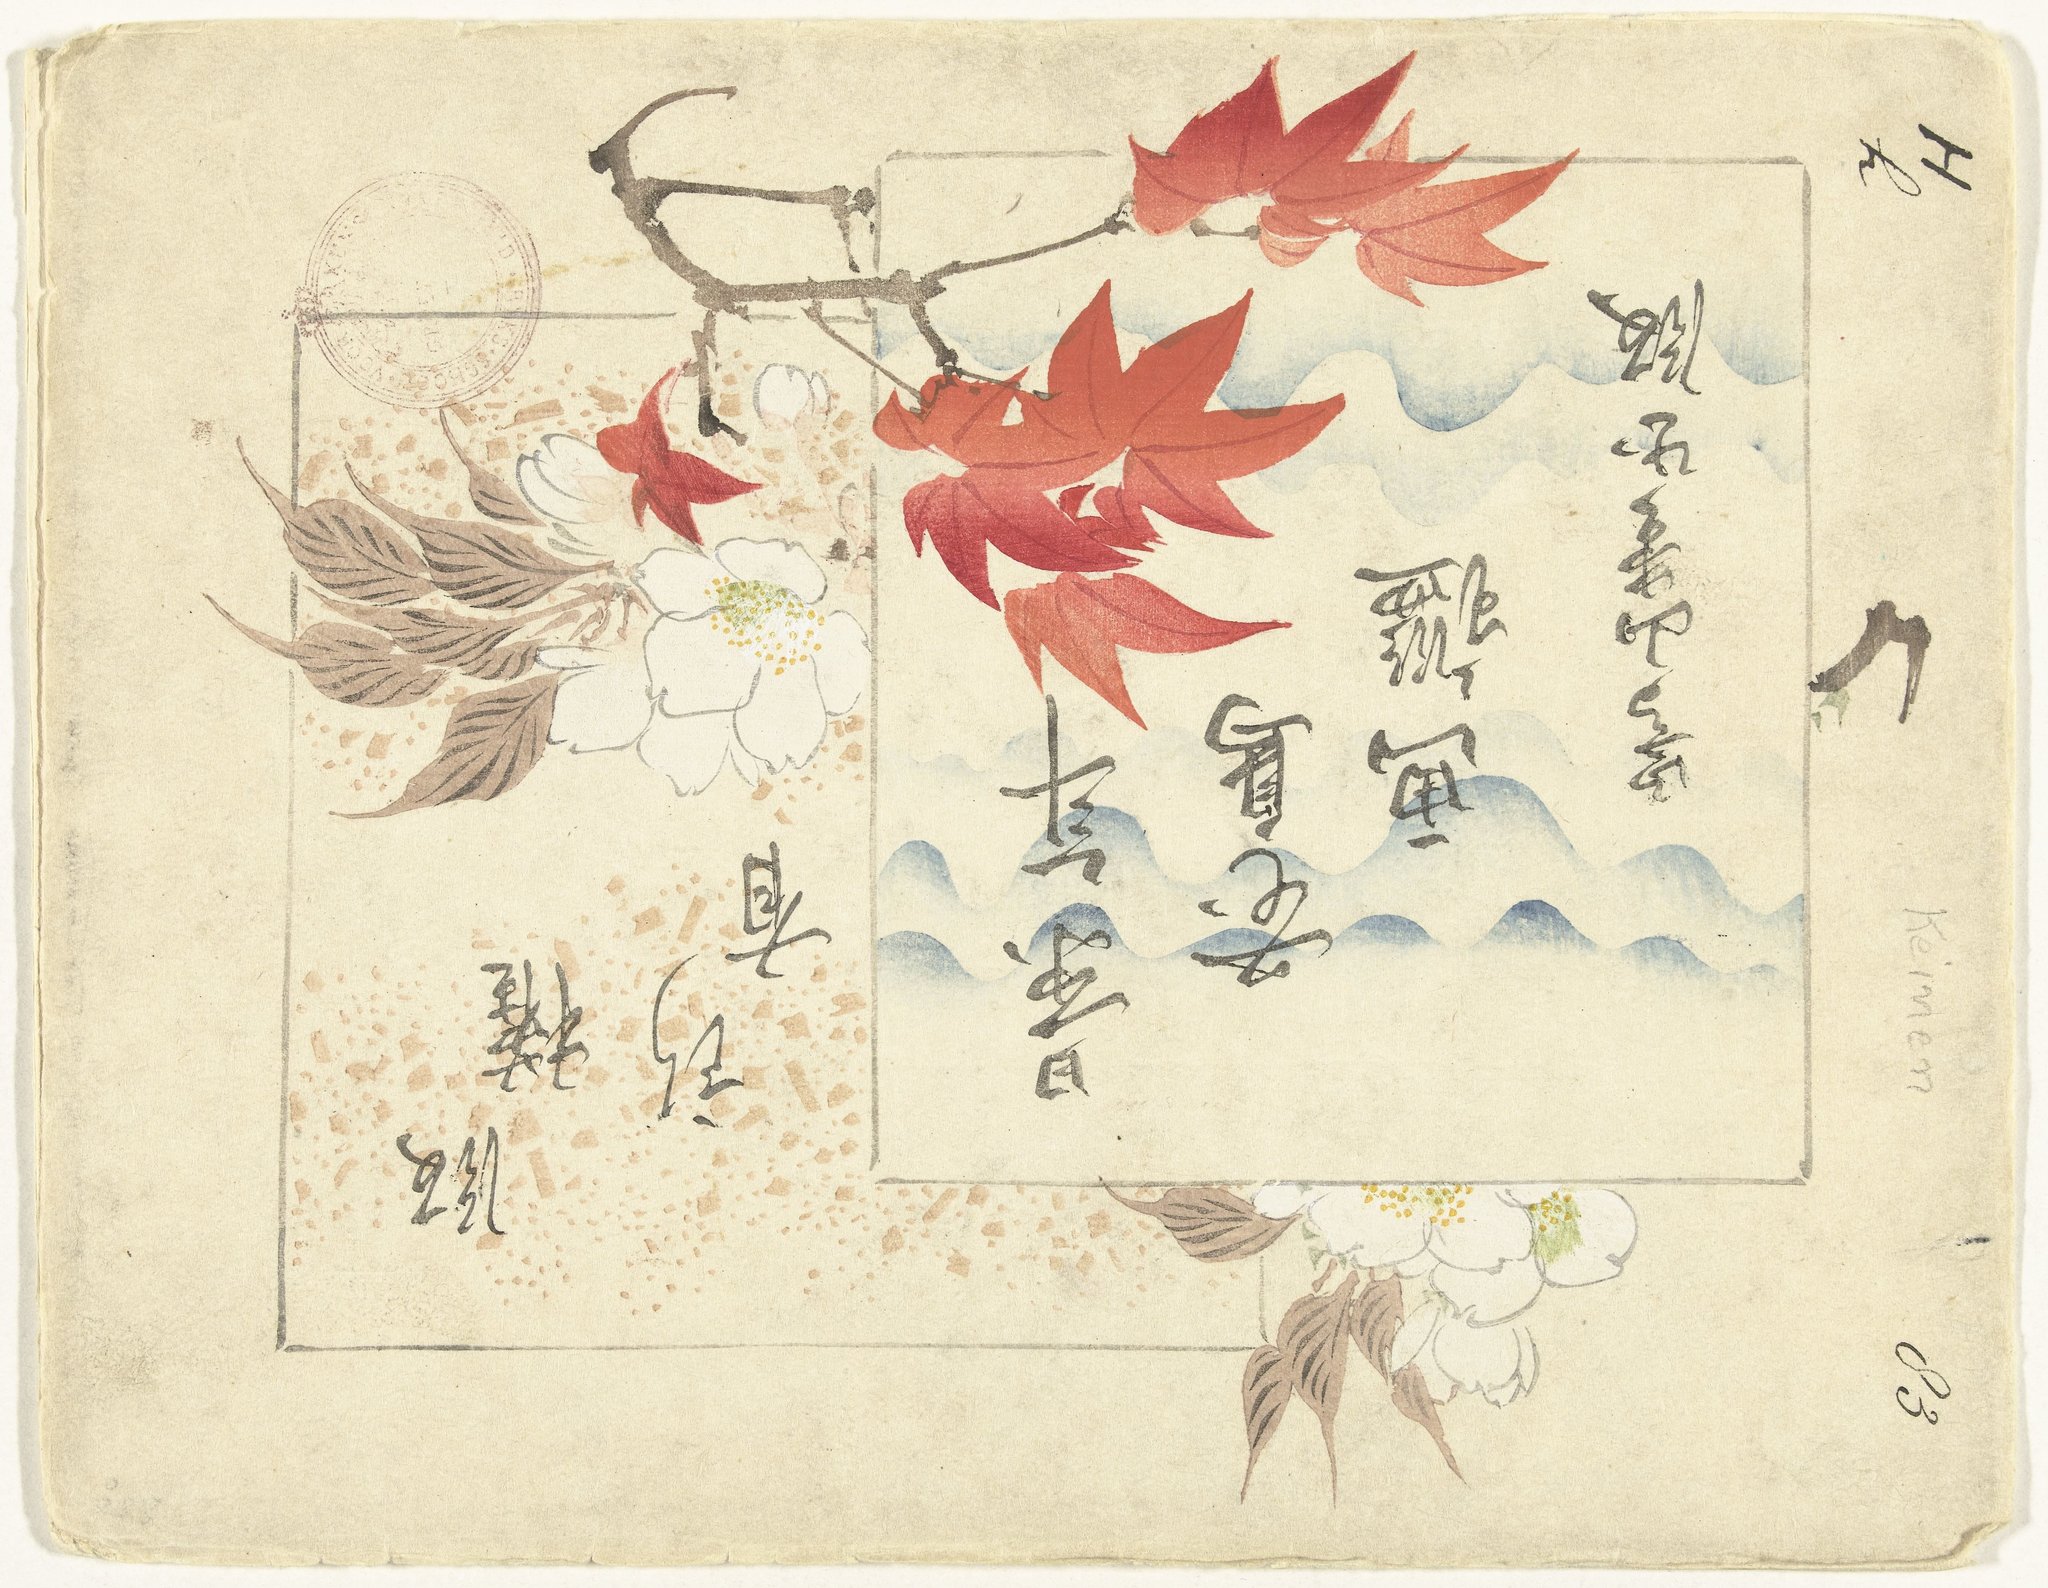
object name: print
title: Inhoudsopgave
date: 1811-1892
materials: paper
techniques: woodcut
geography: osaka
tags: flowers, plants; vegetation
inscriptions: collector's mark: Lugt 2228, collector's mark: ‘Rijksschool voor kunstnijverheid’ Lugt 3937